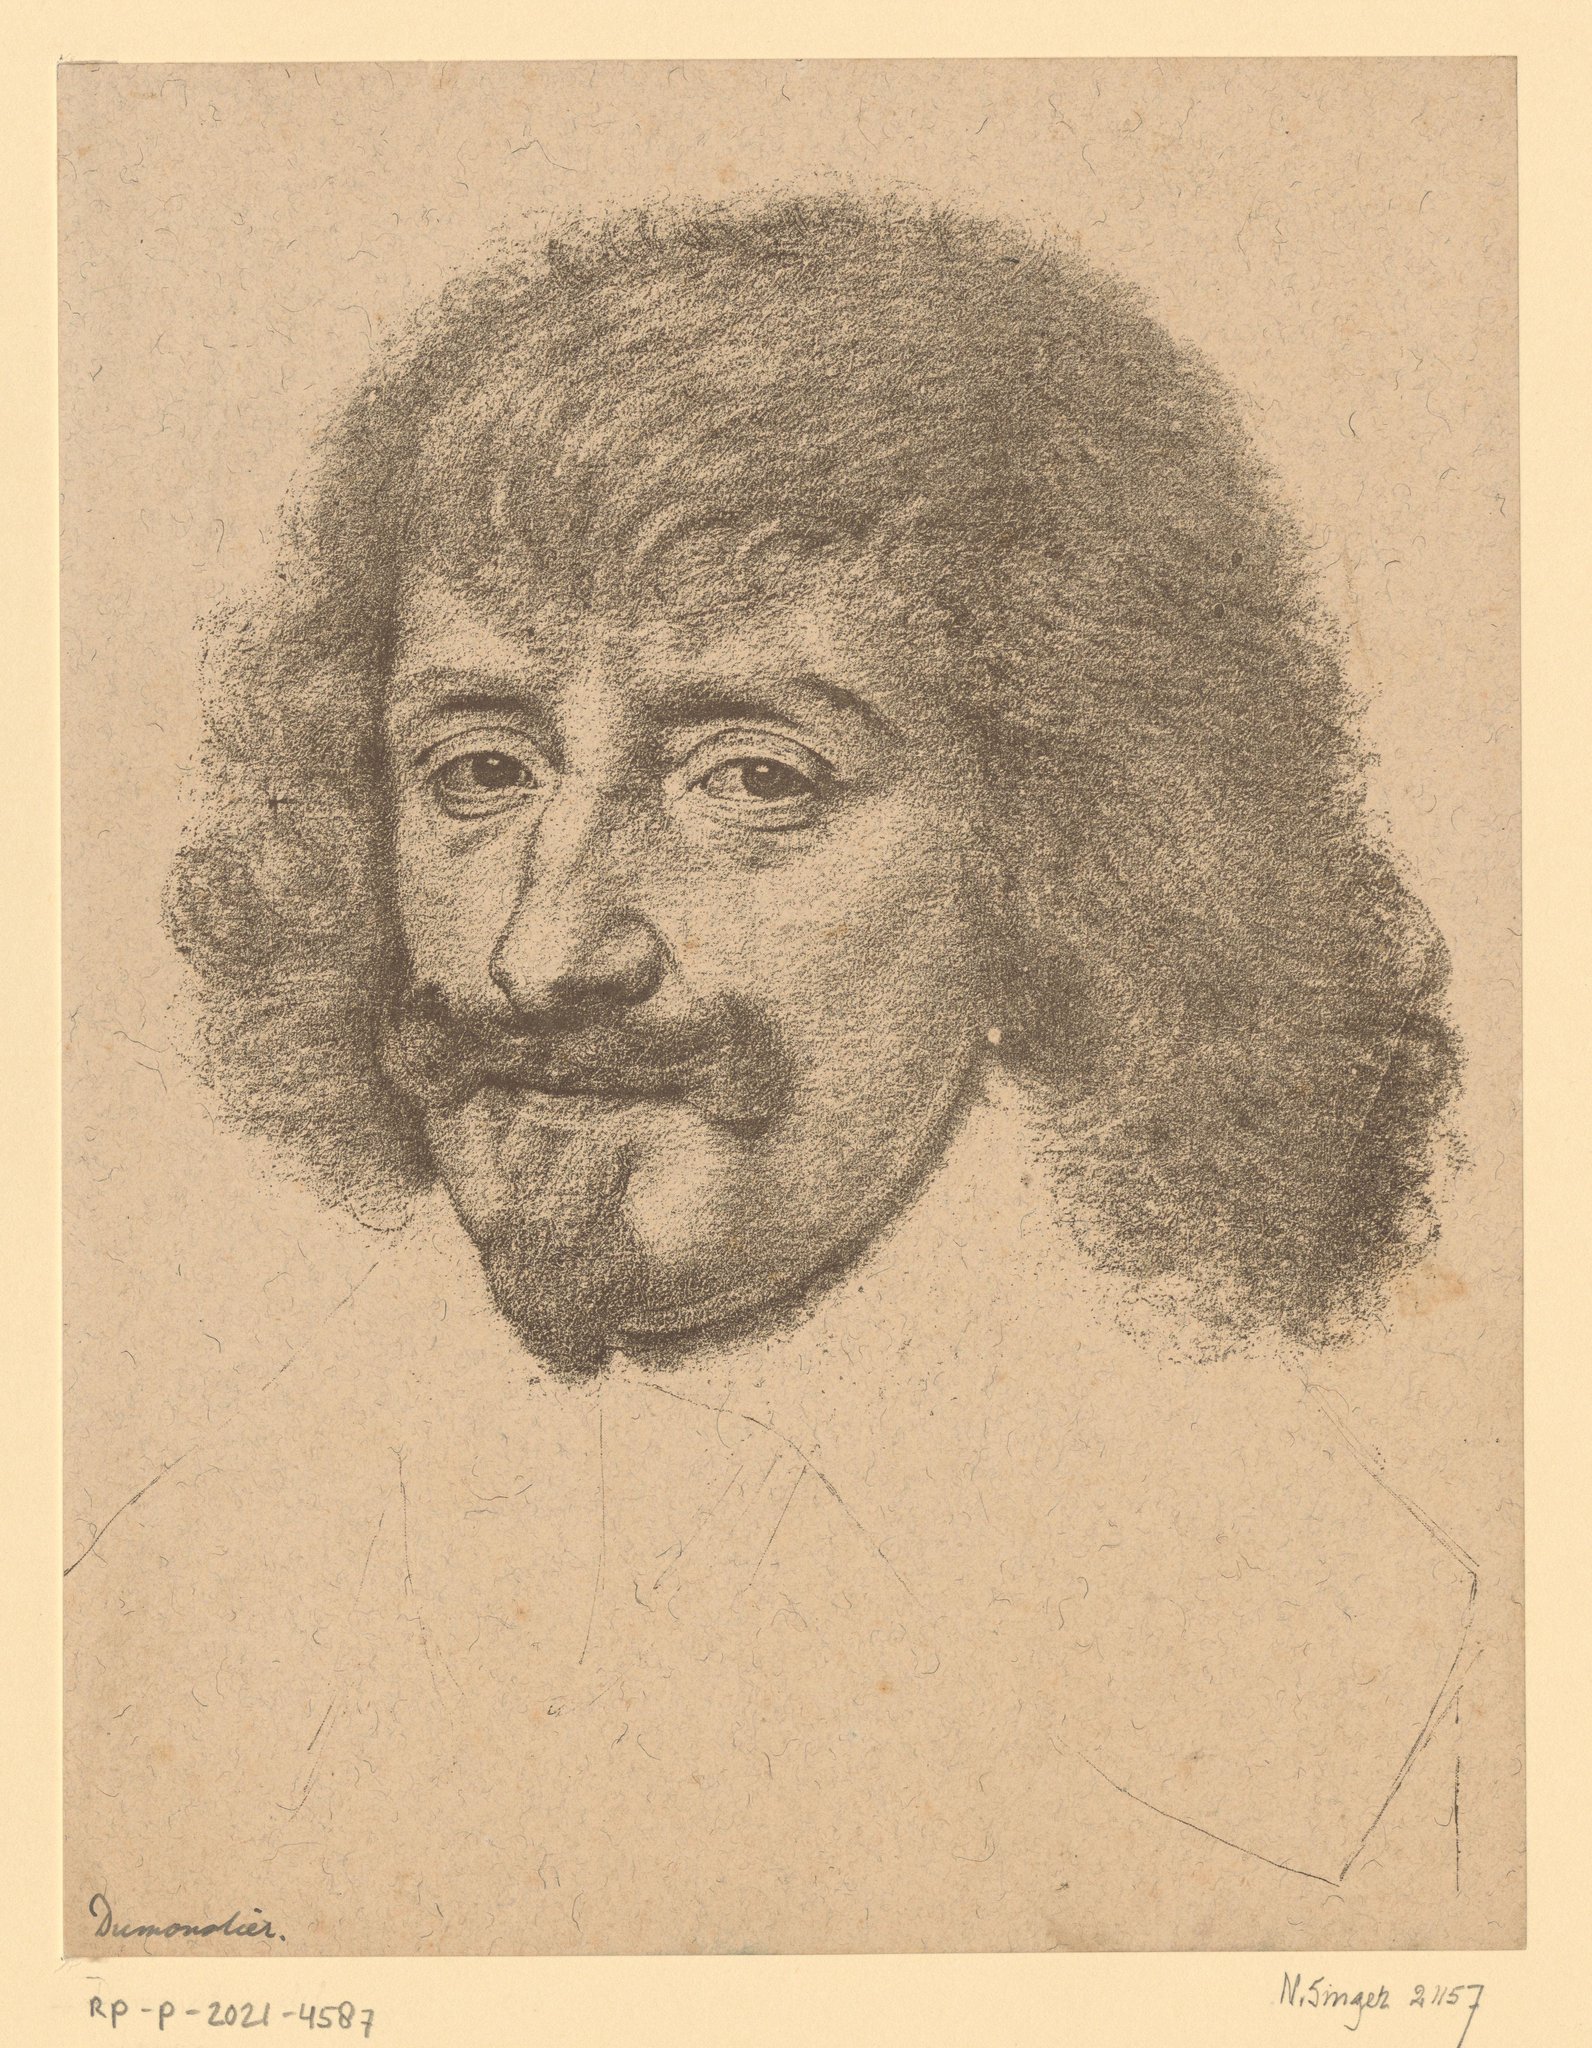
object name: print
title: Portret van Hendrik II van Longueville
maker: Anonymous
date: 1910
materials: paper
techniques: lithograph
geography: france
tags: historical persons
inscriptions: inscription: ‘portr. de duc de Longueville en 1632/ Dessin du Louvre 4./ Louvre. (Dumonstier 2.)’, inscription: ‘Dumonstier’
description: Prent waarschijnlijk uit: Guiffrey, Jean e.a. Inventaire général des dessins du Musée du Louvre et du Musée de Versailles : école Française. Parijs: Musées Nationaux, 1910, dl. 5, p. 59.